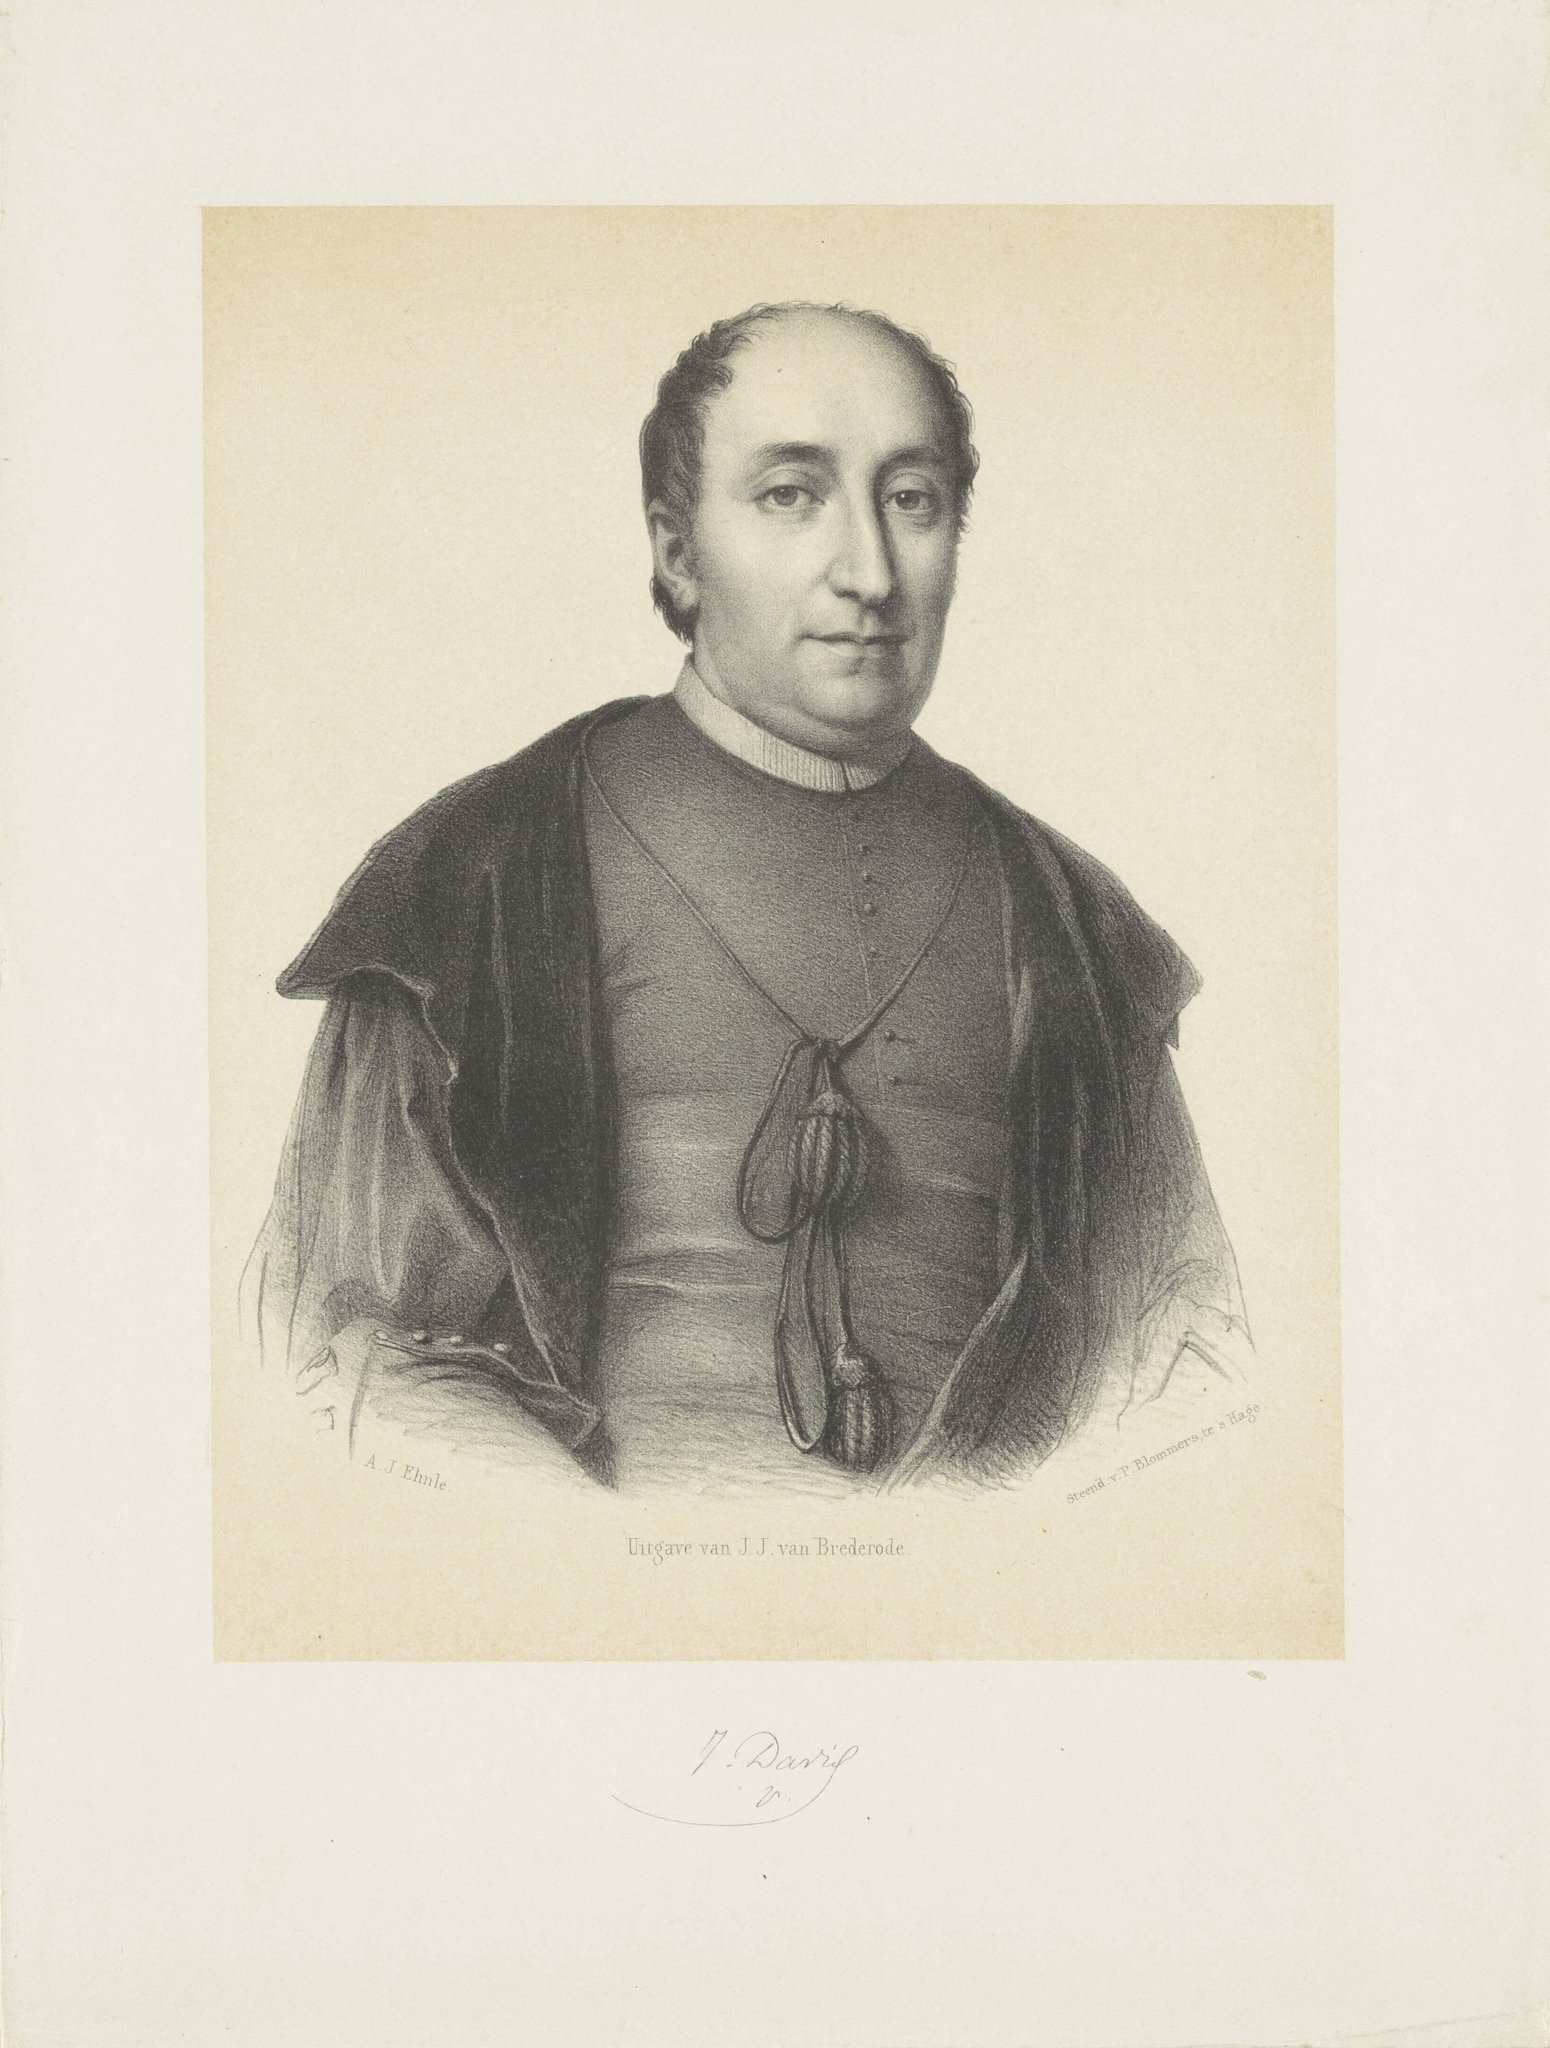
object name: print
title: Portret van Jan Baptist David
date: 1854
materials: paper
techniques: tone lithography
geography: the hague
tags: historical persons (+ (full) bust portrait)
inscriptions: collector's mark: Lugt 2228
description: De geportretteerde draagt een mantel, met een koord dichtgeknoopt voor zijn borst. Onder het portret zijn signatuur.